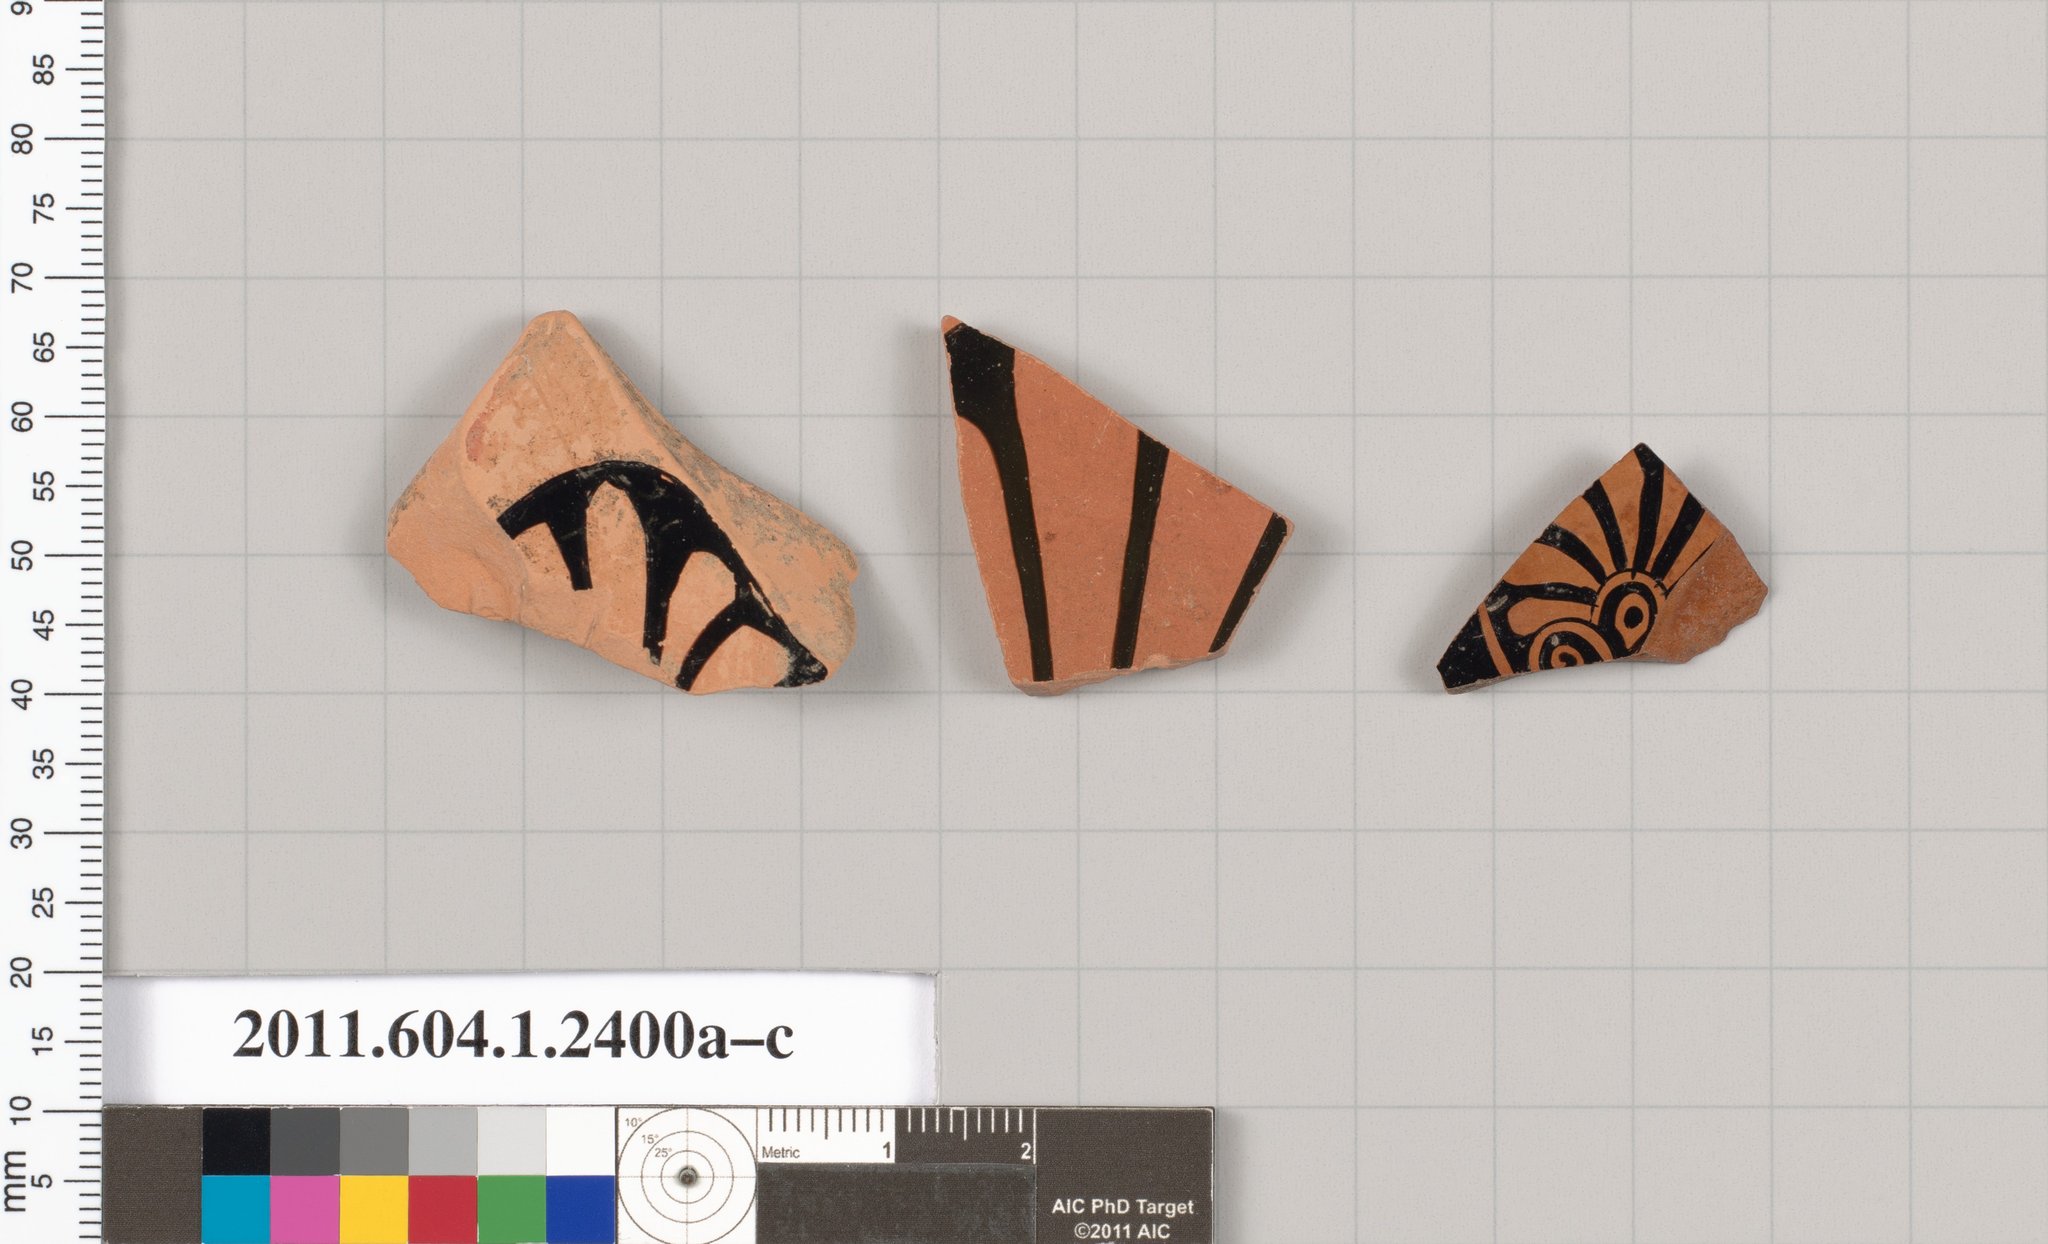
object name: kylix fragment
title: Terracotta fragments of kylikes (drinking cups)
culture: greek, attic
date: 500-401 BCE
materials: terracotta